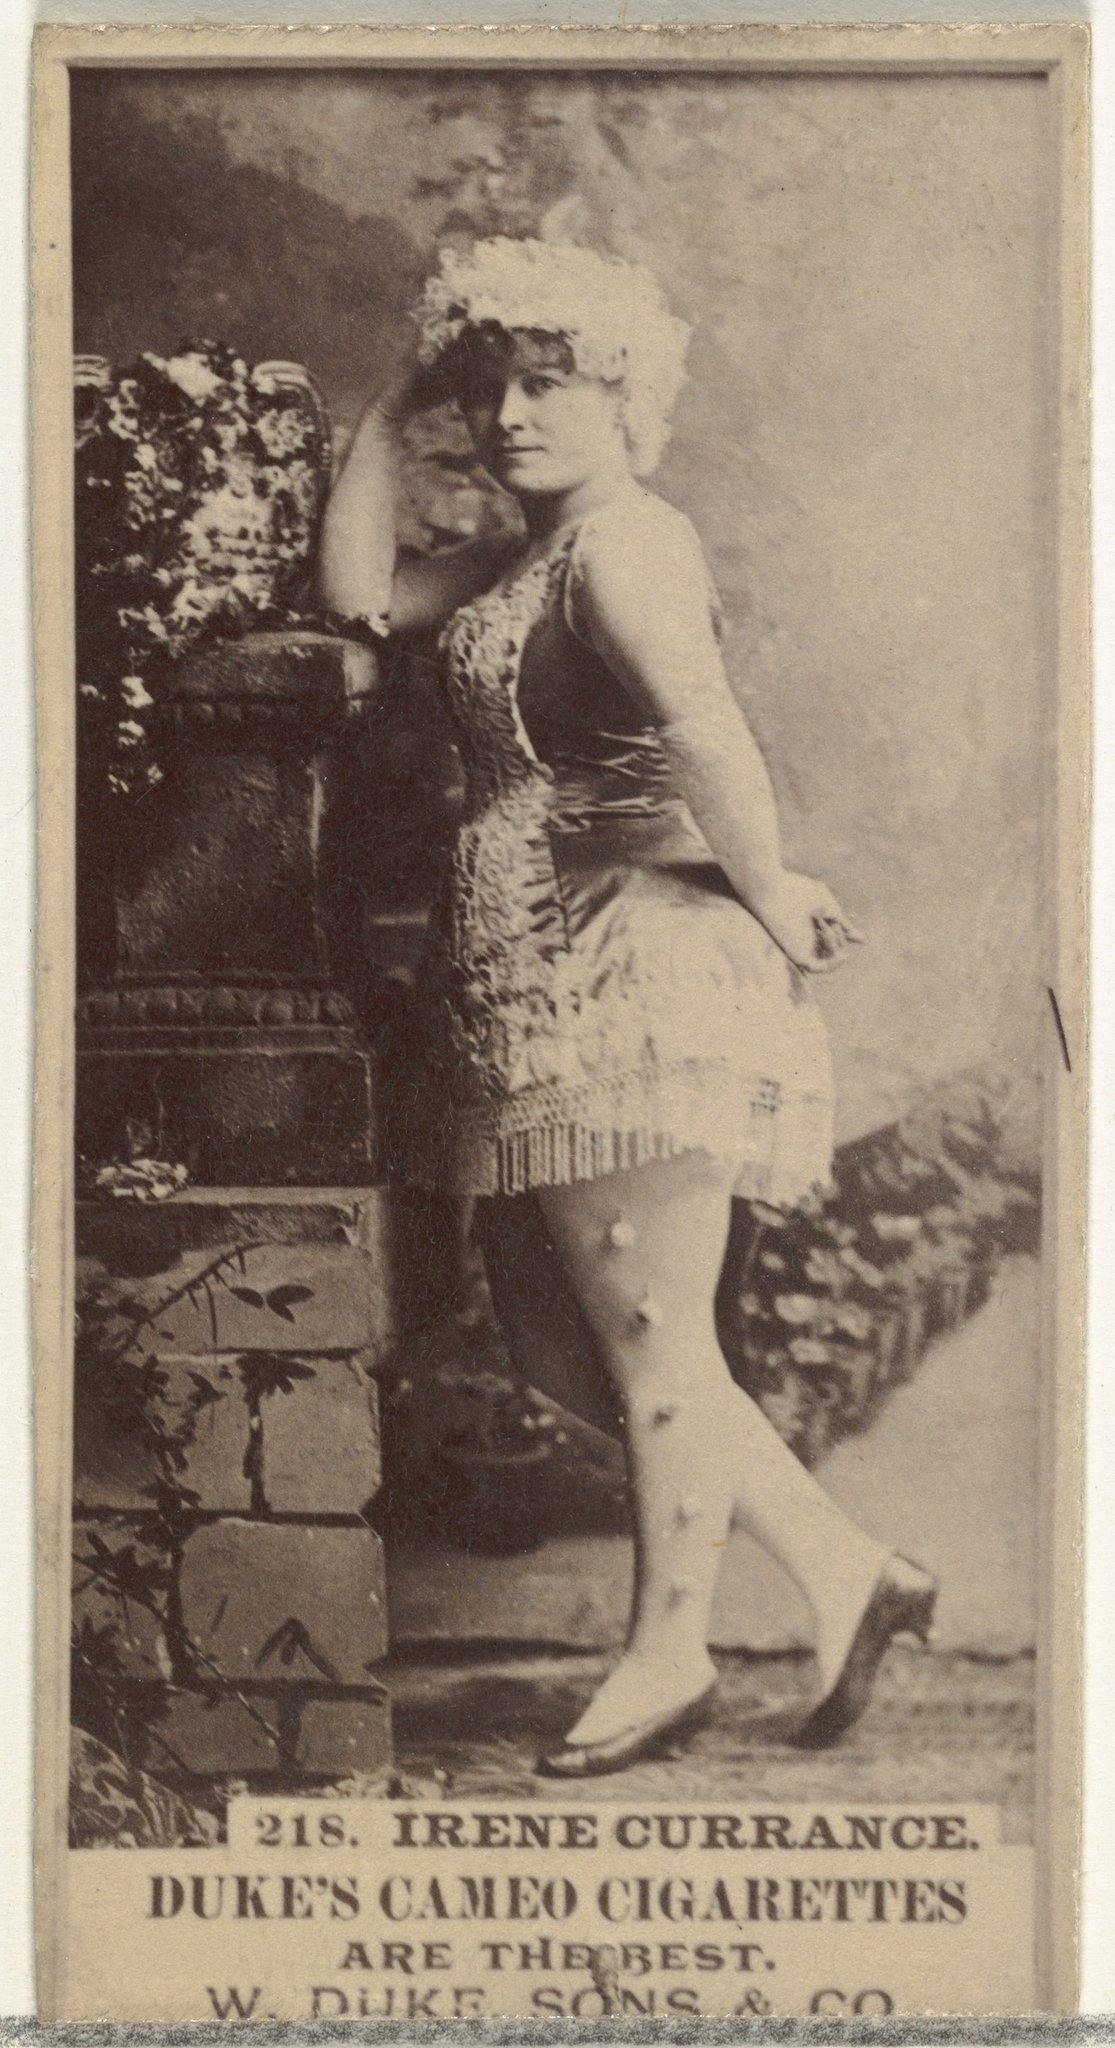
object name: photograph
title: Card Number 218, Irene Currance, from the Actors and Actresses series (N145-5) issued by Duke Sons & Co. to promote Cameo Cigarettes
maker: w. duke, sons & co.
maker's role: publisher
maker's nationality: american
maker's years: 1870-1920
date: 1880-1889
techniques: albumen silver print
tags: portraits,women,actresses